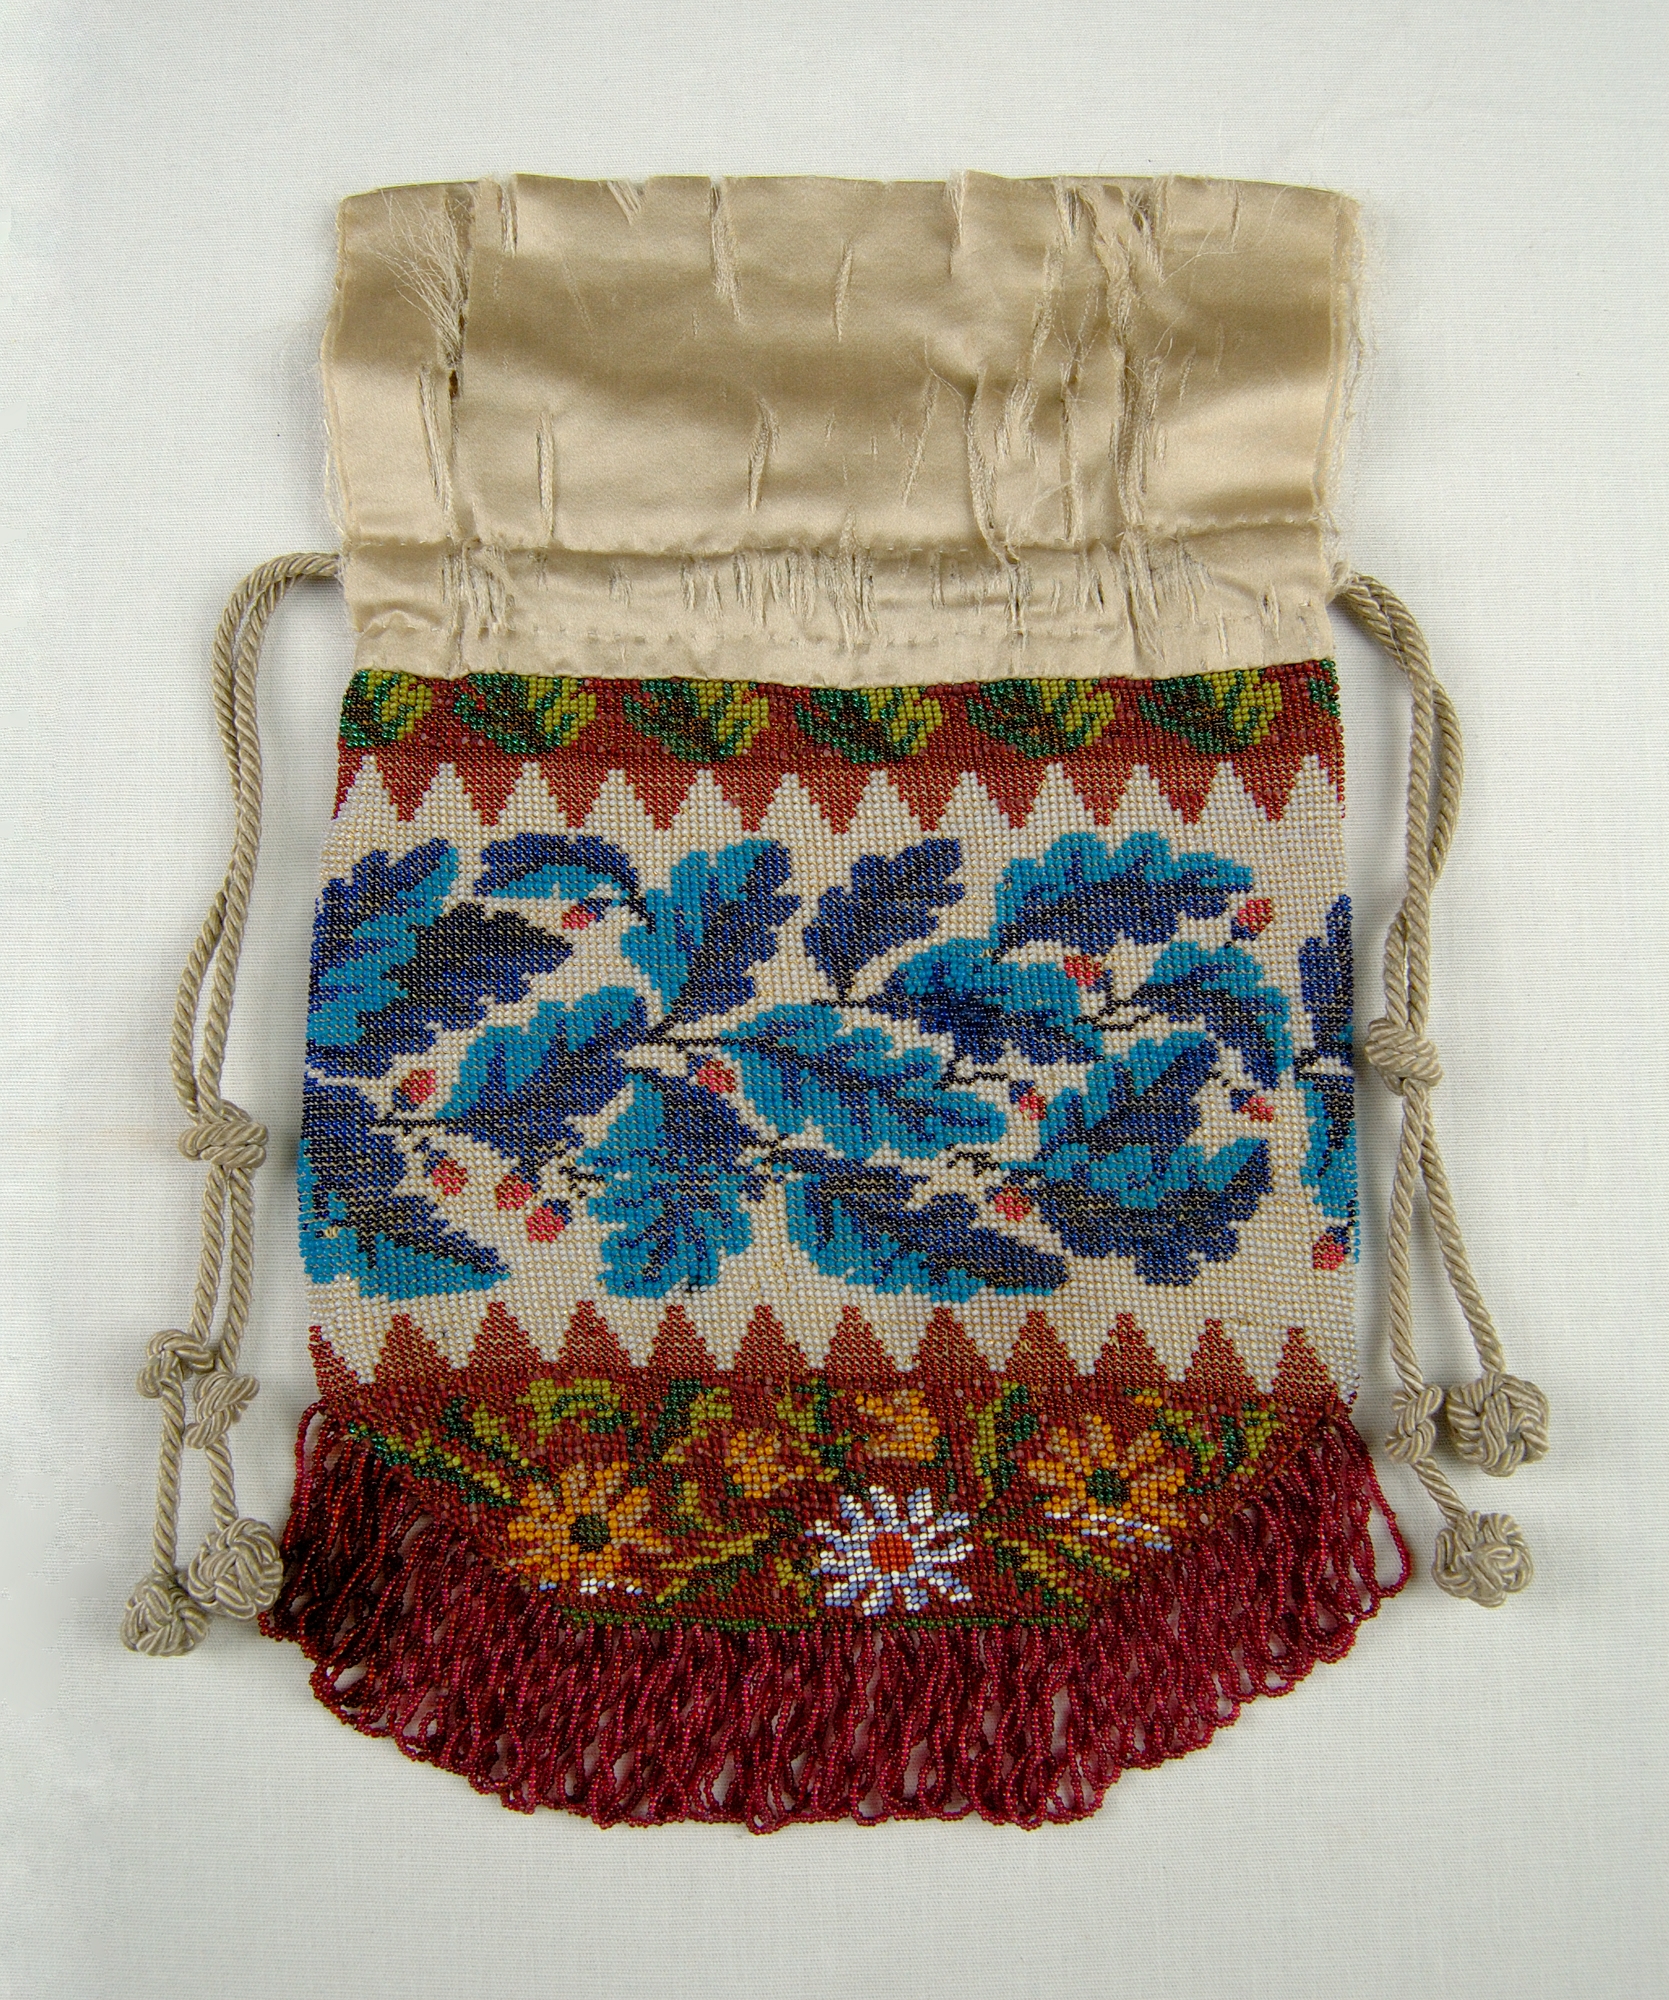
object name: pouch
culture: american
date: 1830-1860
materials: glass, linen, silk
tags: flowers,leaves